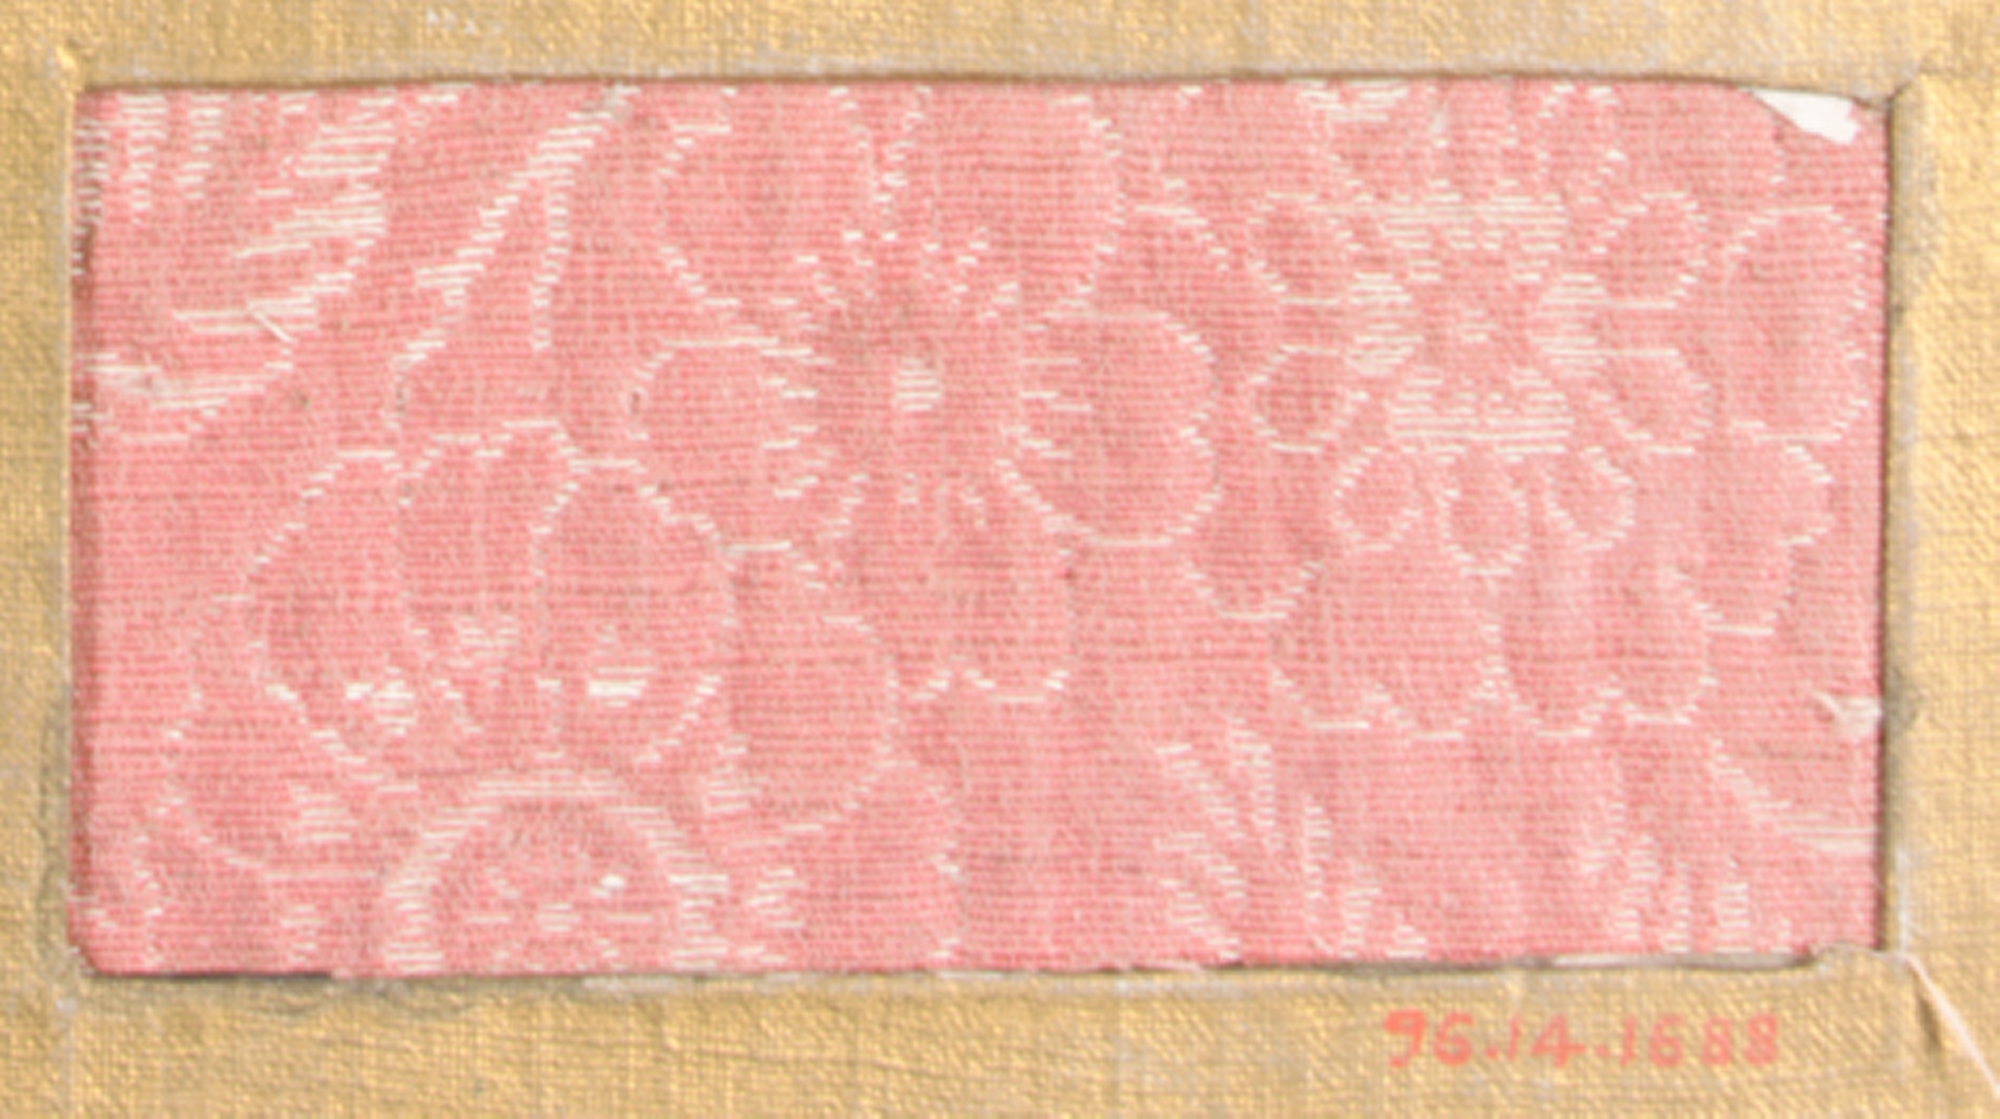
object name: piece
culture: japanese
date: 1701-1900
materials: silk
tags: flowers